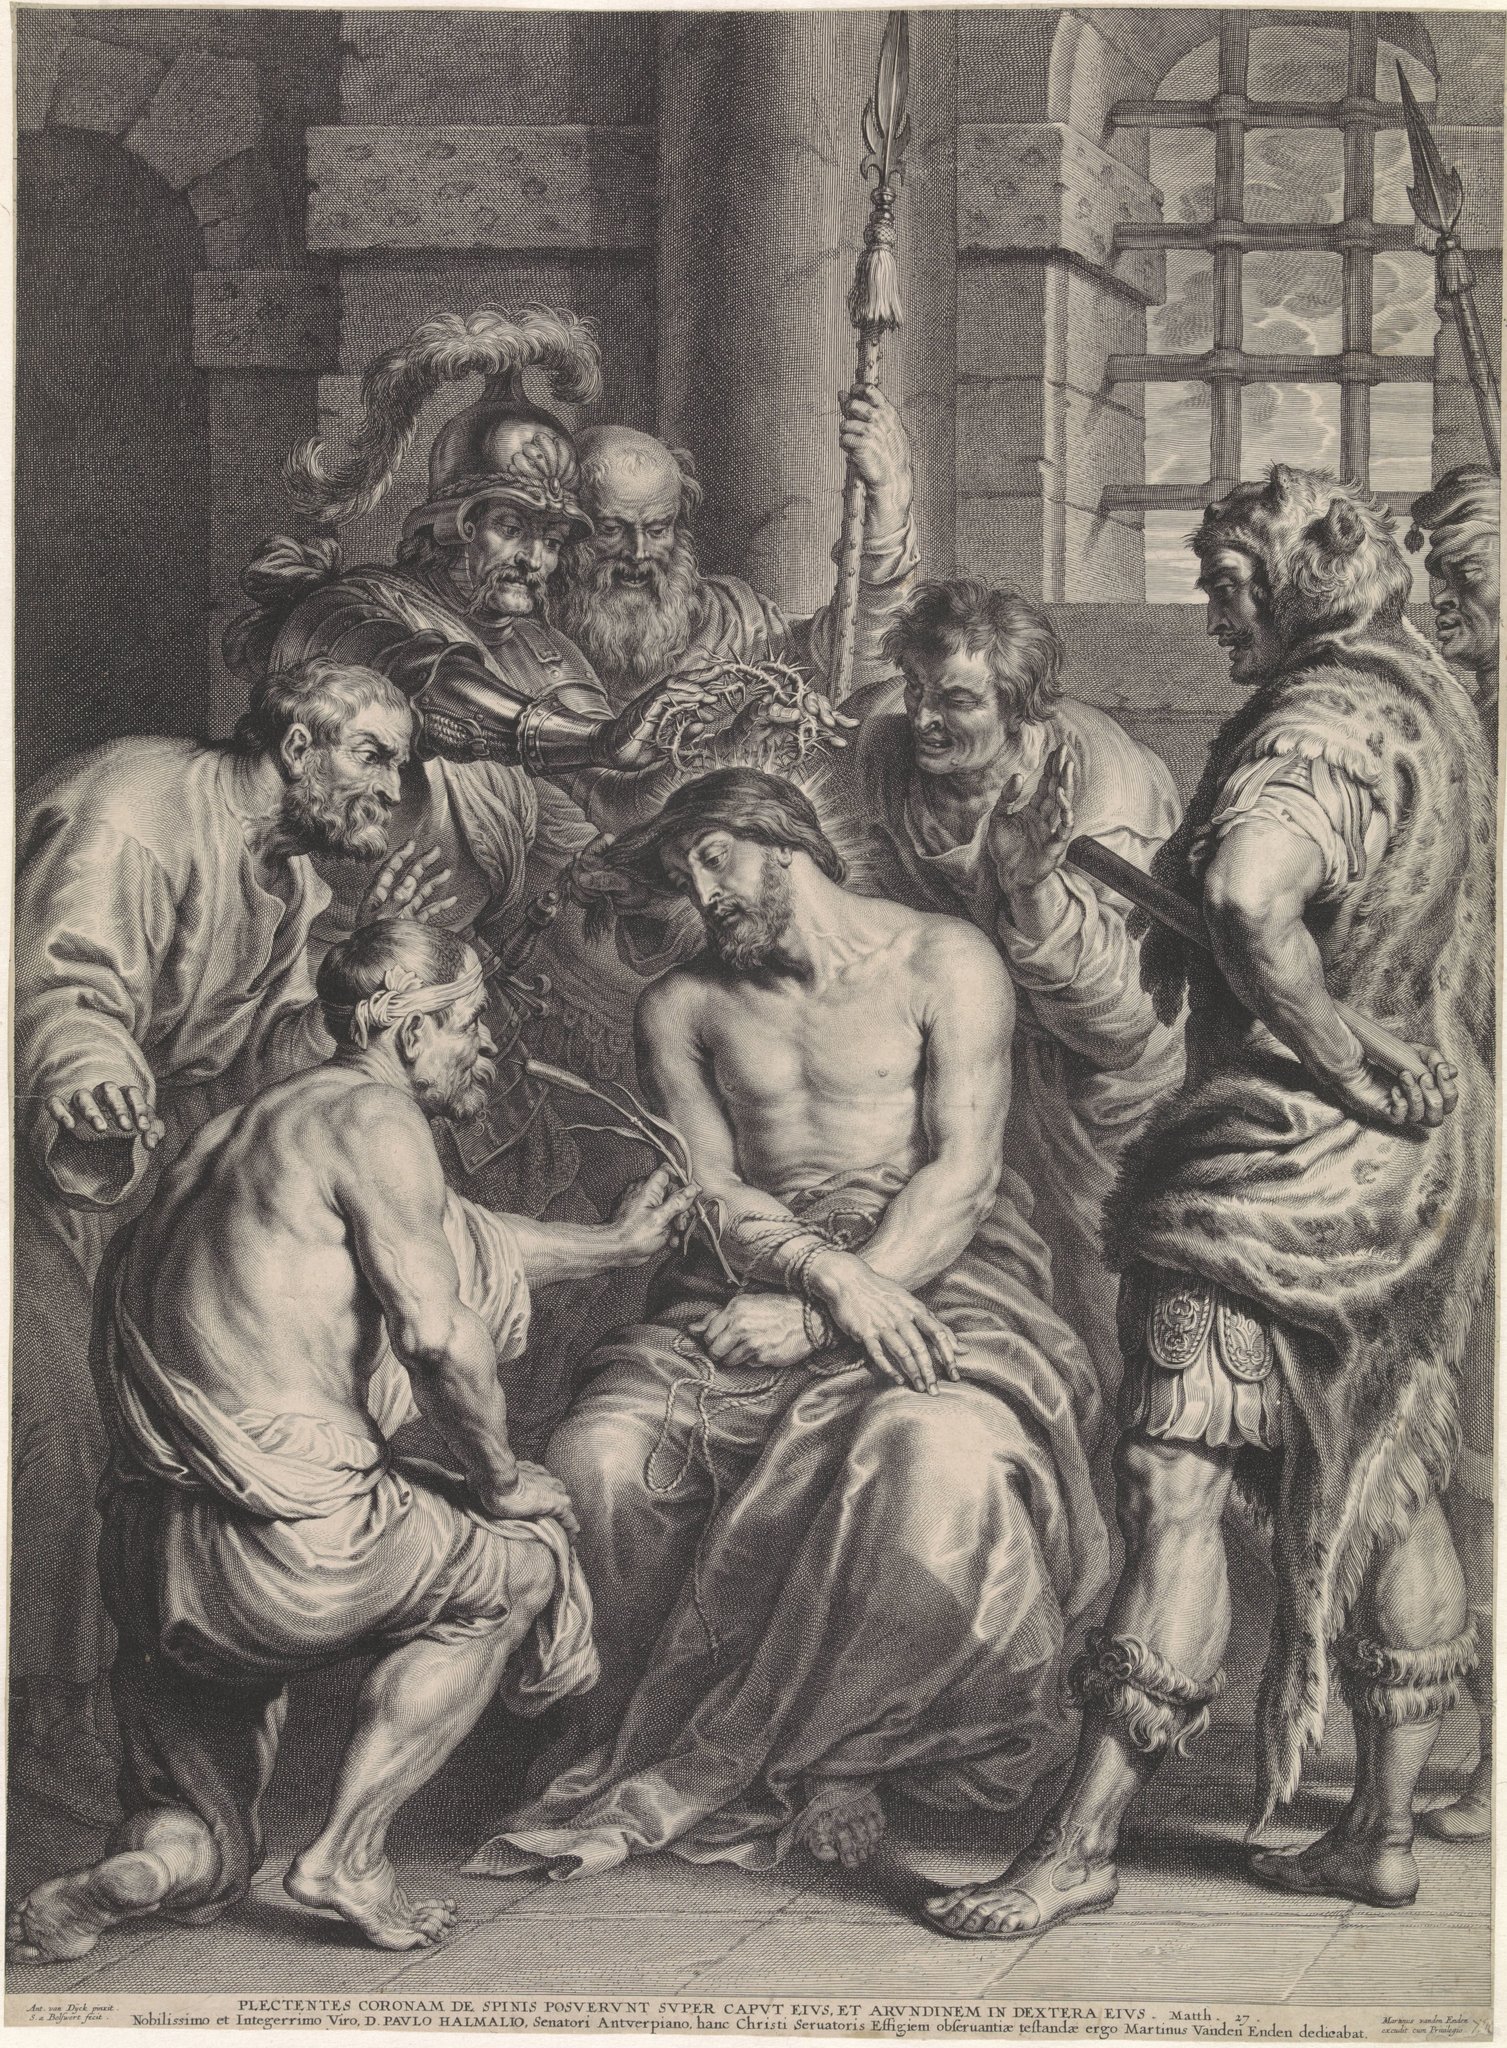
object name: print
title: Doornenkroning van Christus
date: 1596-1659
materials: paper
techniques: engraving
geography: netherlands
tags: the crowning with thorns: soldiers with sticks place a thorny crown on christ's head and give him a reed (matthew 27:27-31; mark 15:16-20; john 19:2-3)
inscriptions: collector's mark: Lugt 240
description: Doornenkroning van Christus. In de marge onder fragment van bijbeltekst Matteüs 27.